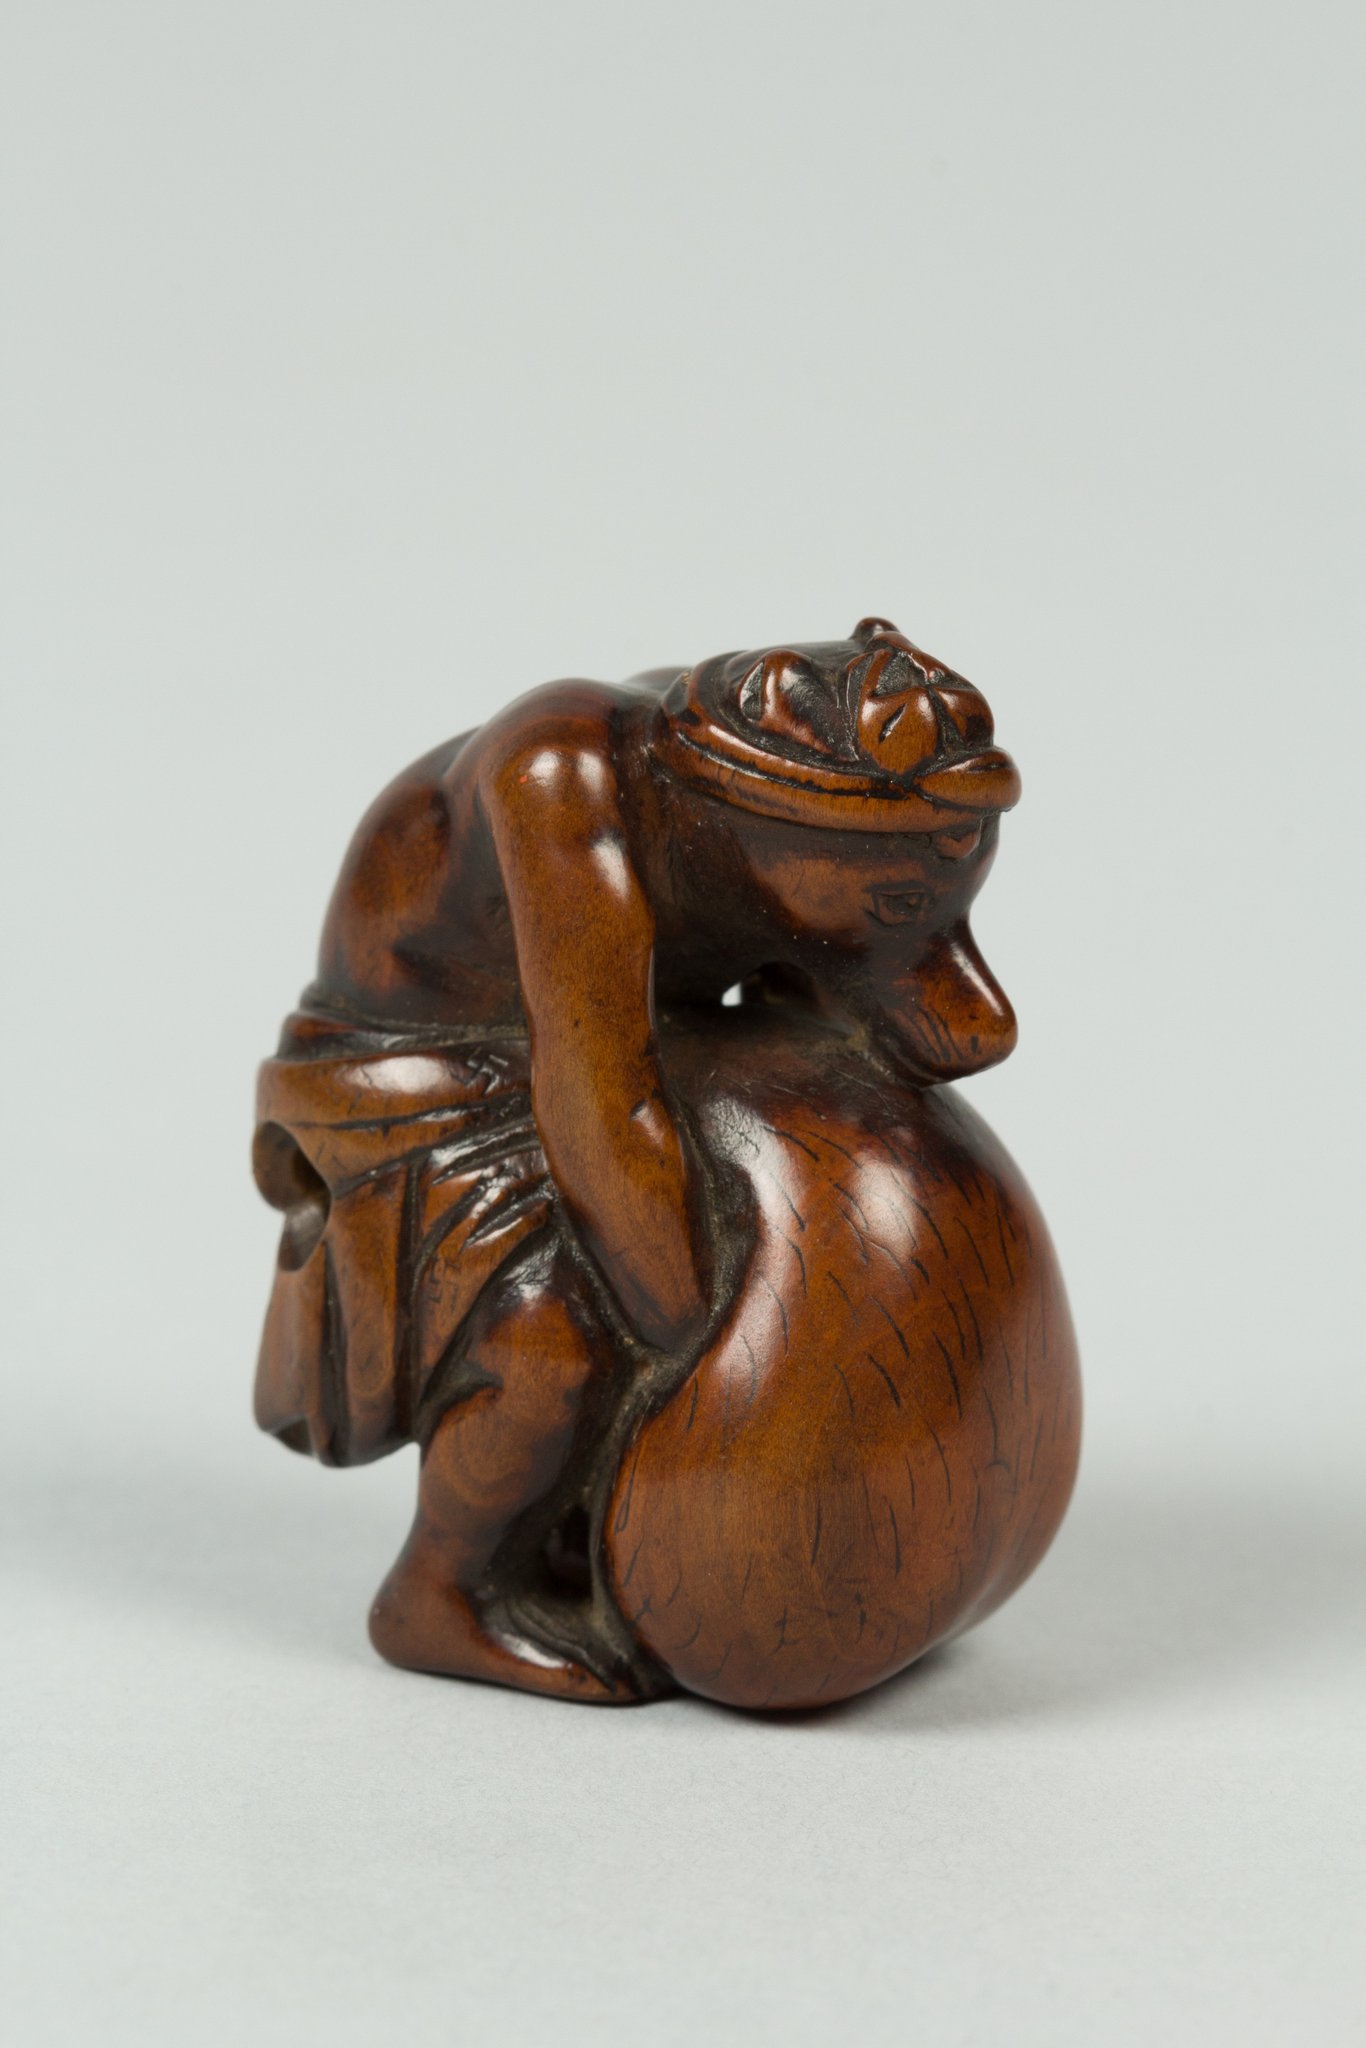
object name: netsuke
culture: japanese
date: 1801-1900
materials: wood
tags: mythical creatures